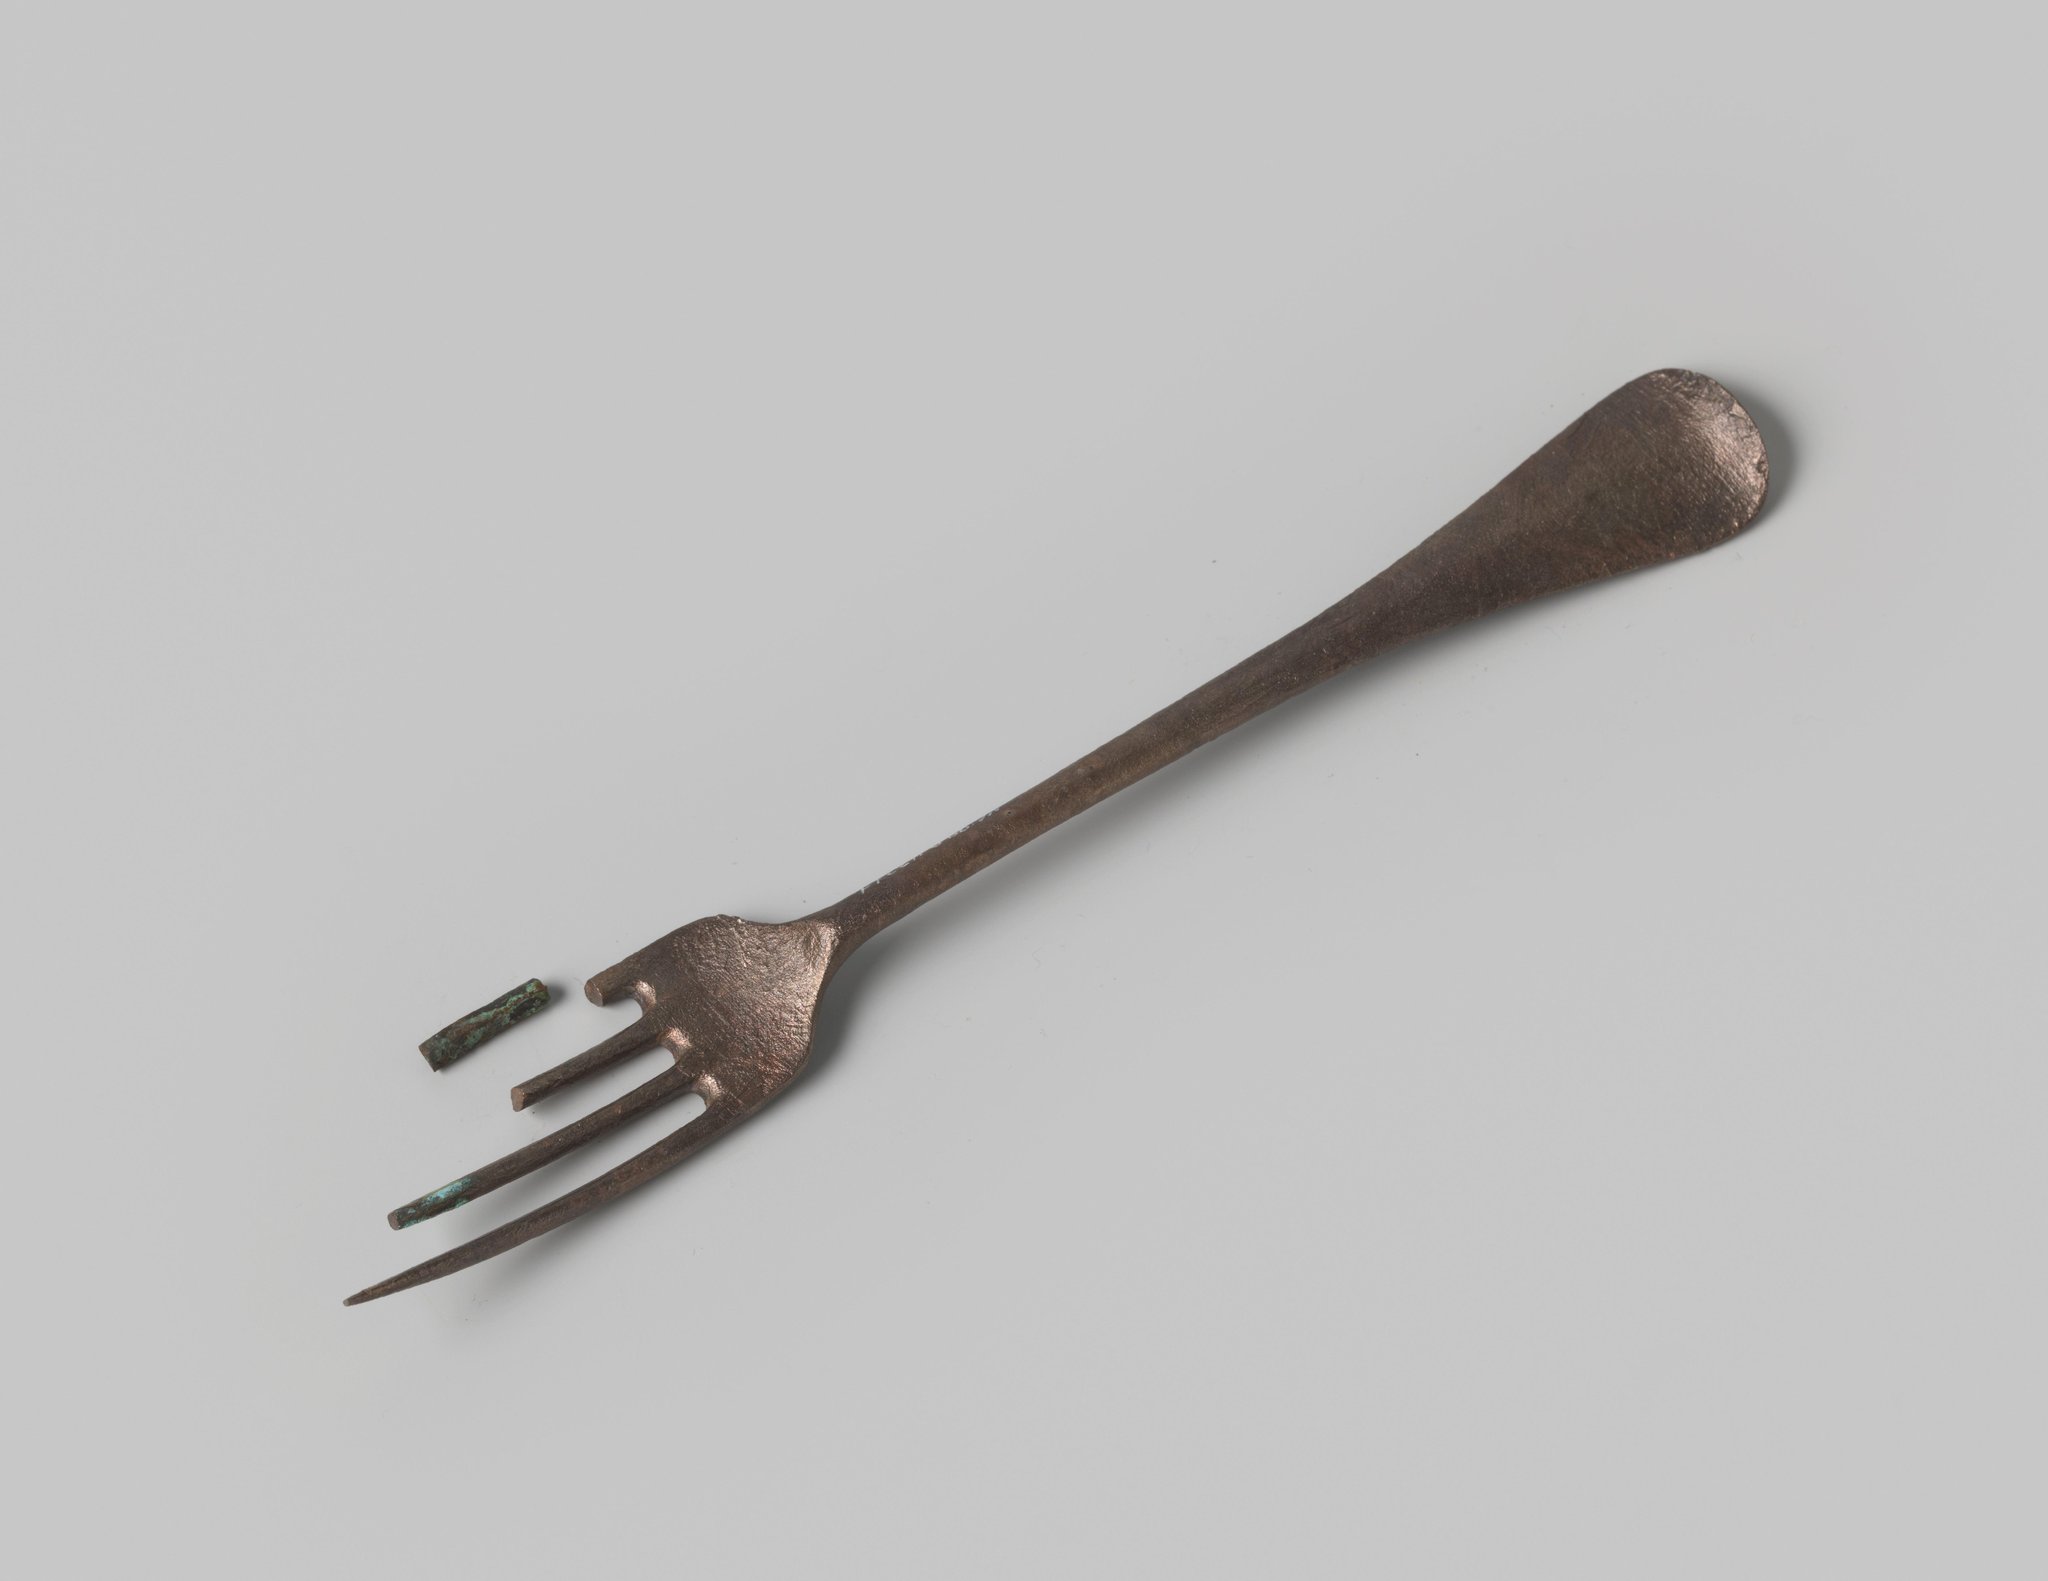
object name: fork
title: Vork met losse tand uit het wrak van de Oost-Indiëvaarder Hollandia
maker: Anonymous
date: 1700-1743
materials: copper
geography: netherlands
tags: verenigde oostindische compagnie, hollandia (schip), annet